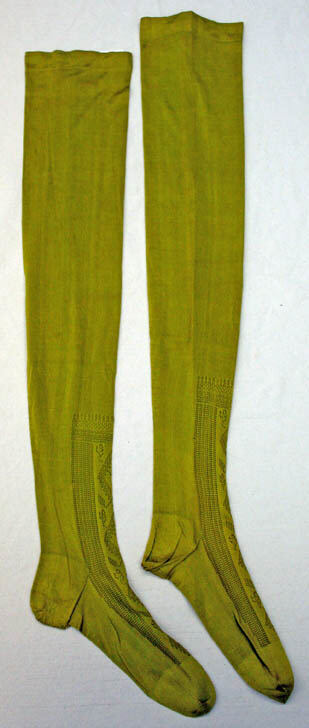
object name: stocking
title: Stockings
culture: french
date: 1801-1900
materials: silk